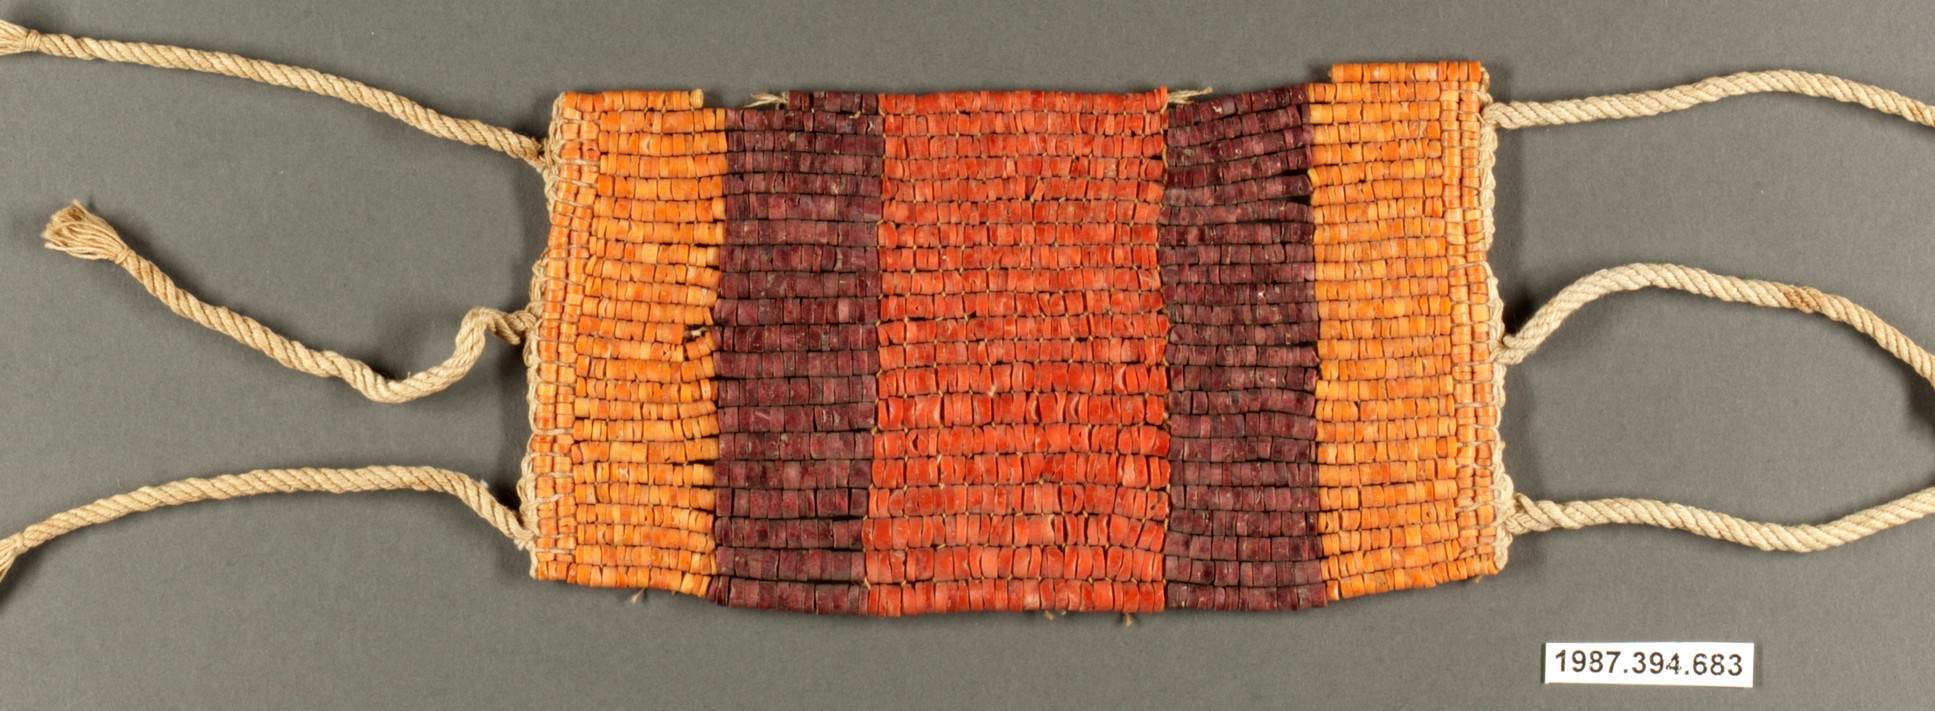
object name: bracelet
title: Beaded Wrist Ornament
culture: chancay or chimú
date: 1301-1500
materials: cotton, shell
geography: peru